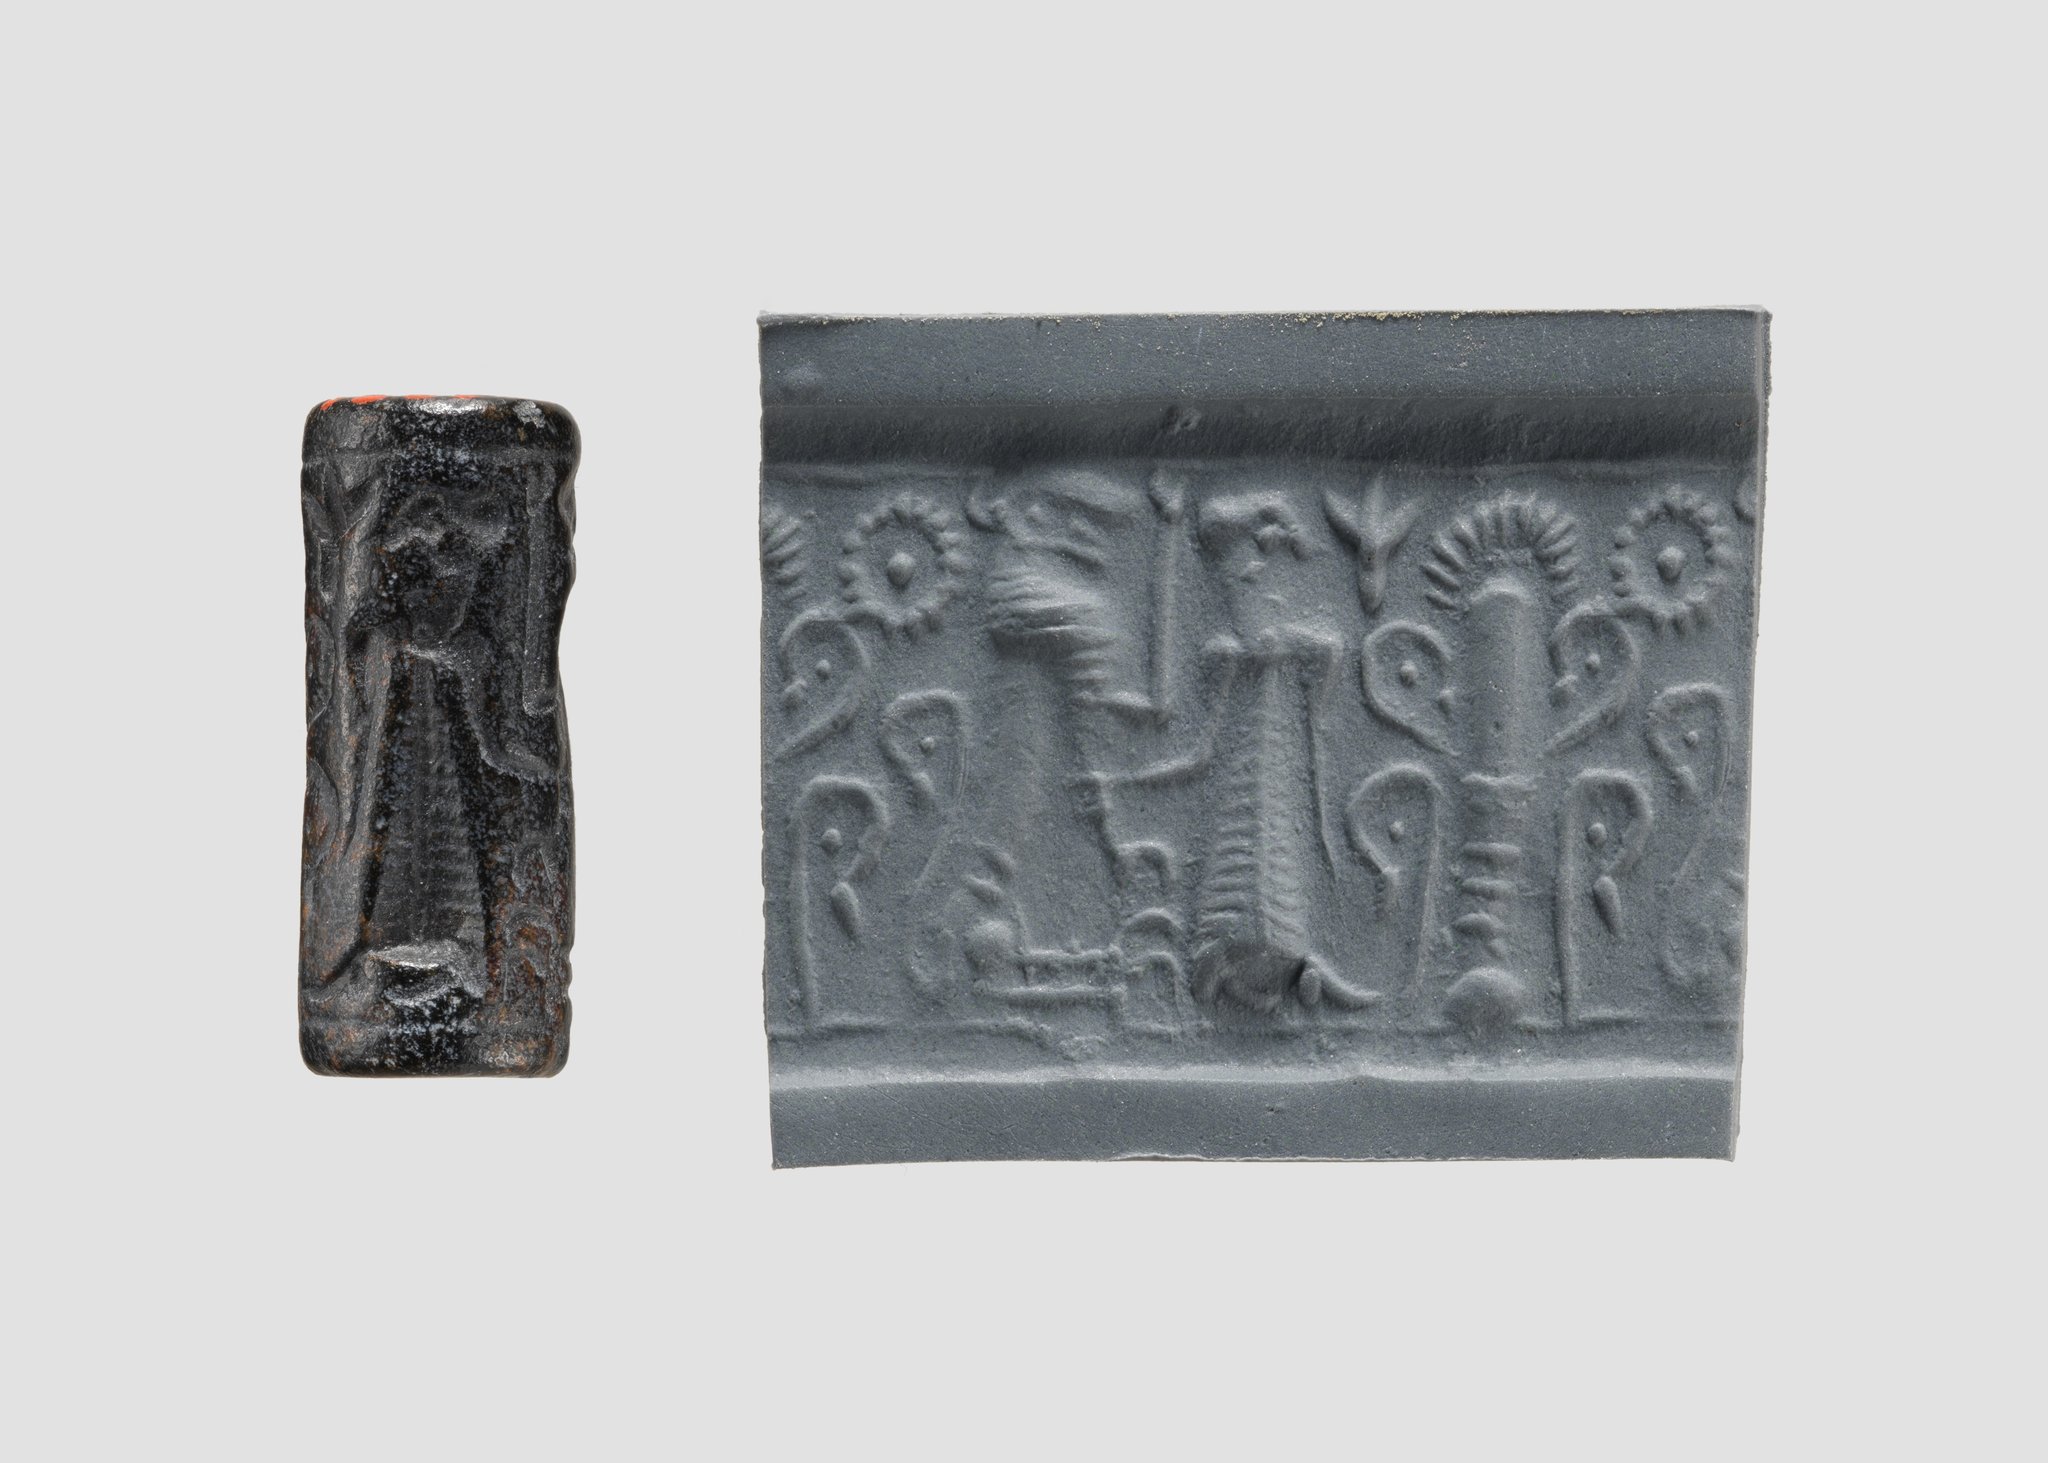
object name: cylinder seal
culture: cypriot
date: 1500-1101 BCE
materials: stone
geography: cyprus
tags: women,lions,trees